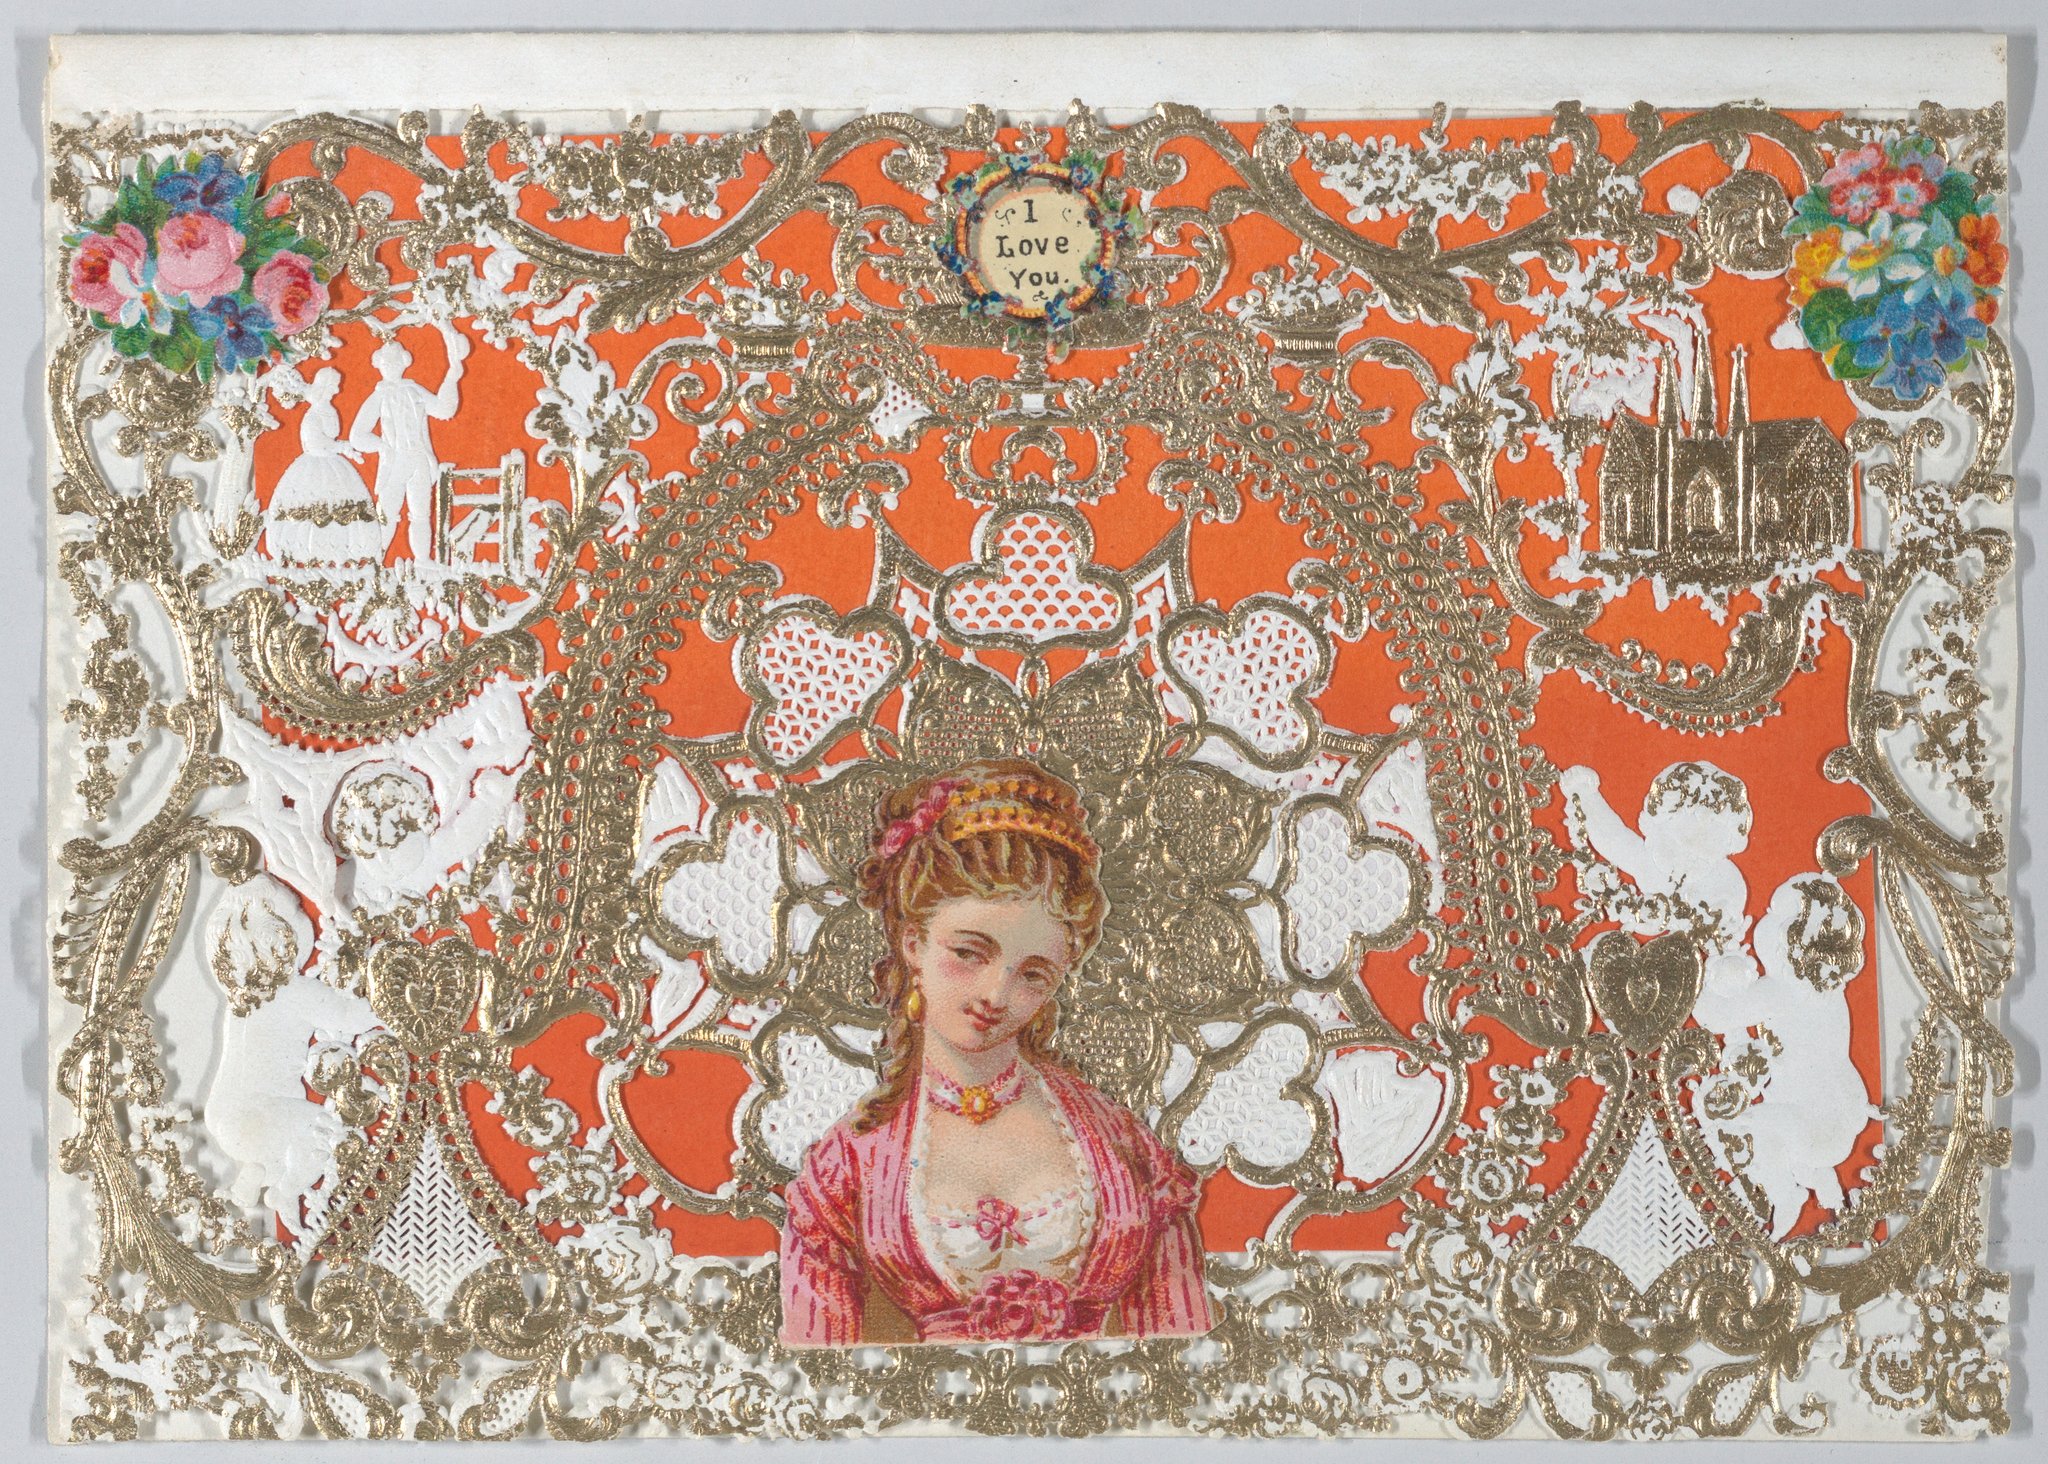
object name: valentine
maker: Anonymous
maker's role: artist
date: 1860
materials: paper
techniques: chromolithography, embossing, gilding, open work